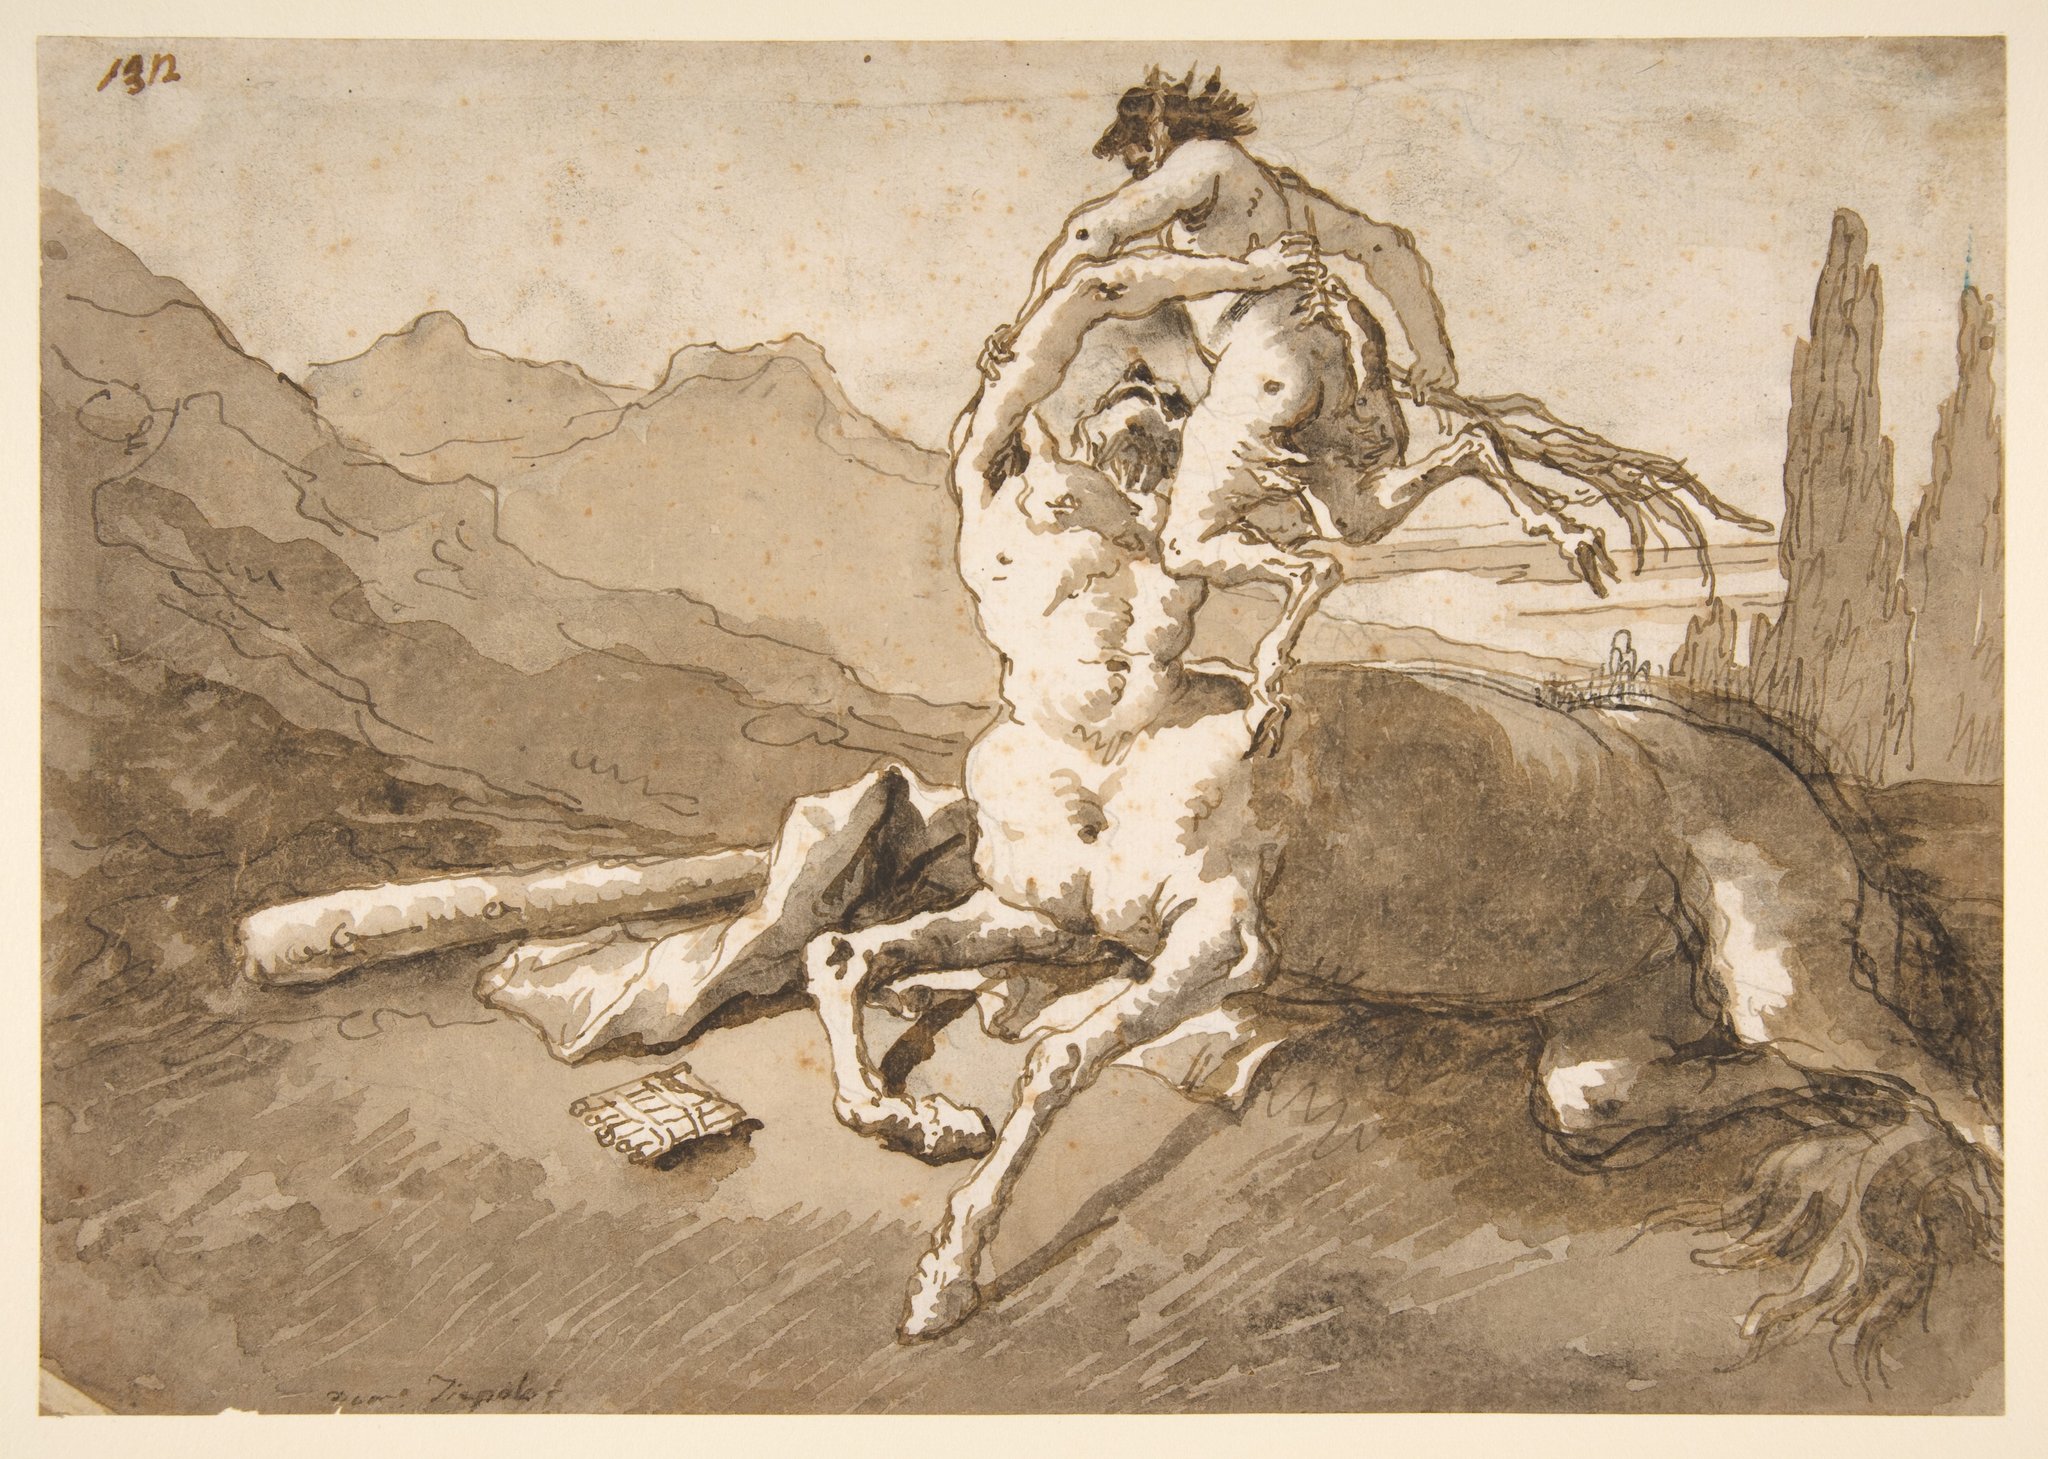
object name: drawing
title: Centaur Holding Up a Youthful Satyr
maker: giovanni domenico tiepolo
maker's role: artist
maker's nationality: italian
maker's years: 1727-1804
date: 1727-1804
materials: graphite, ink, lead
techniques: brush, pen, wash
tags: centaurs,satyrs